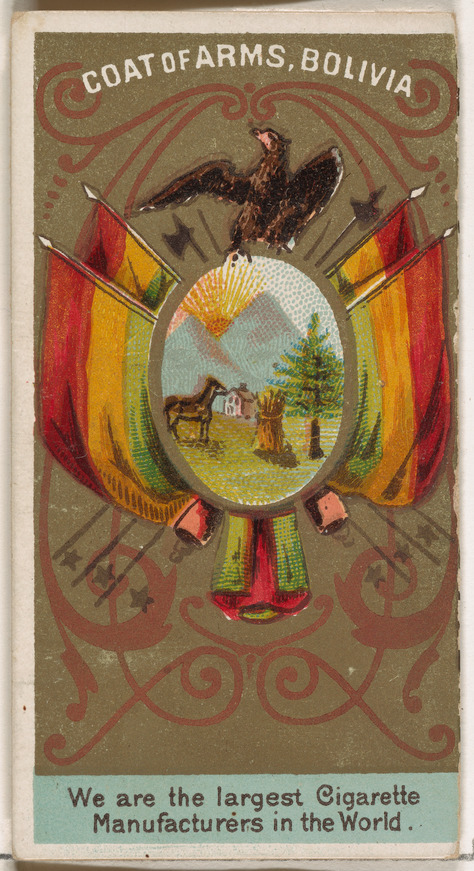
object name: print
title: G. Pacheto, President of Bolivia, from the Rulers, Flags, and Coats of Arms series (N126-2) issued by W. Duke, Sons & Co.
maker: w. duke, sons & co.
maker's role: publisher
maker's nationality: american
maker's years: 1870-1920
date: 1888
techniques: color lithograph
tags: men,portraits,coat of arms,flags